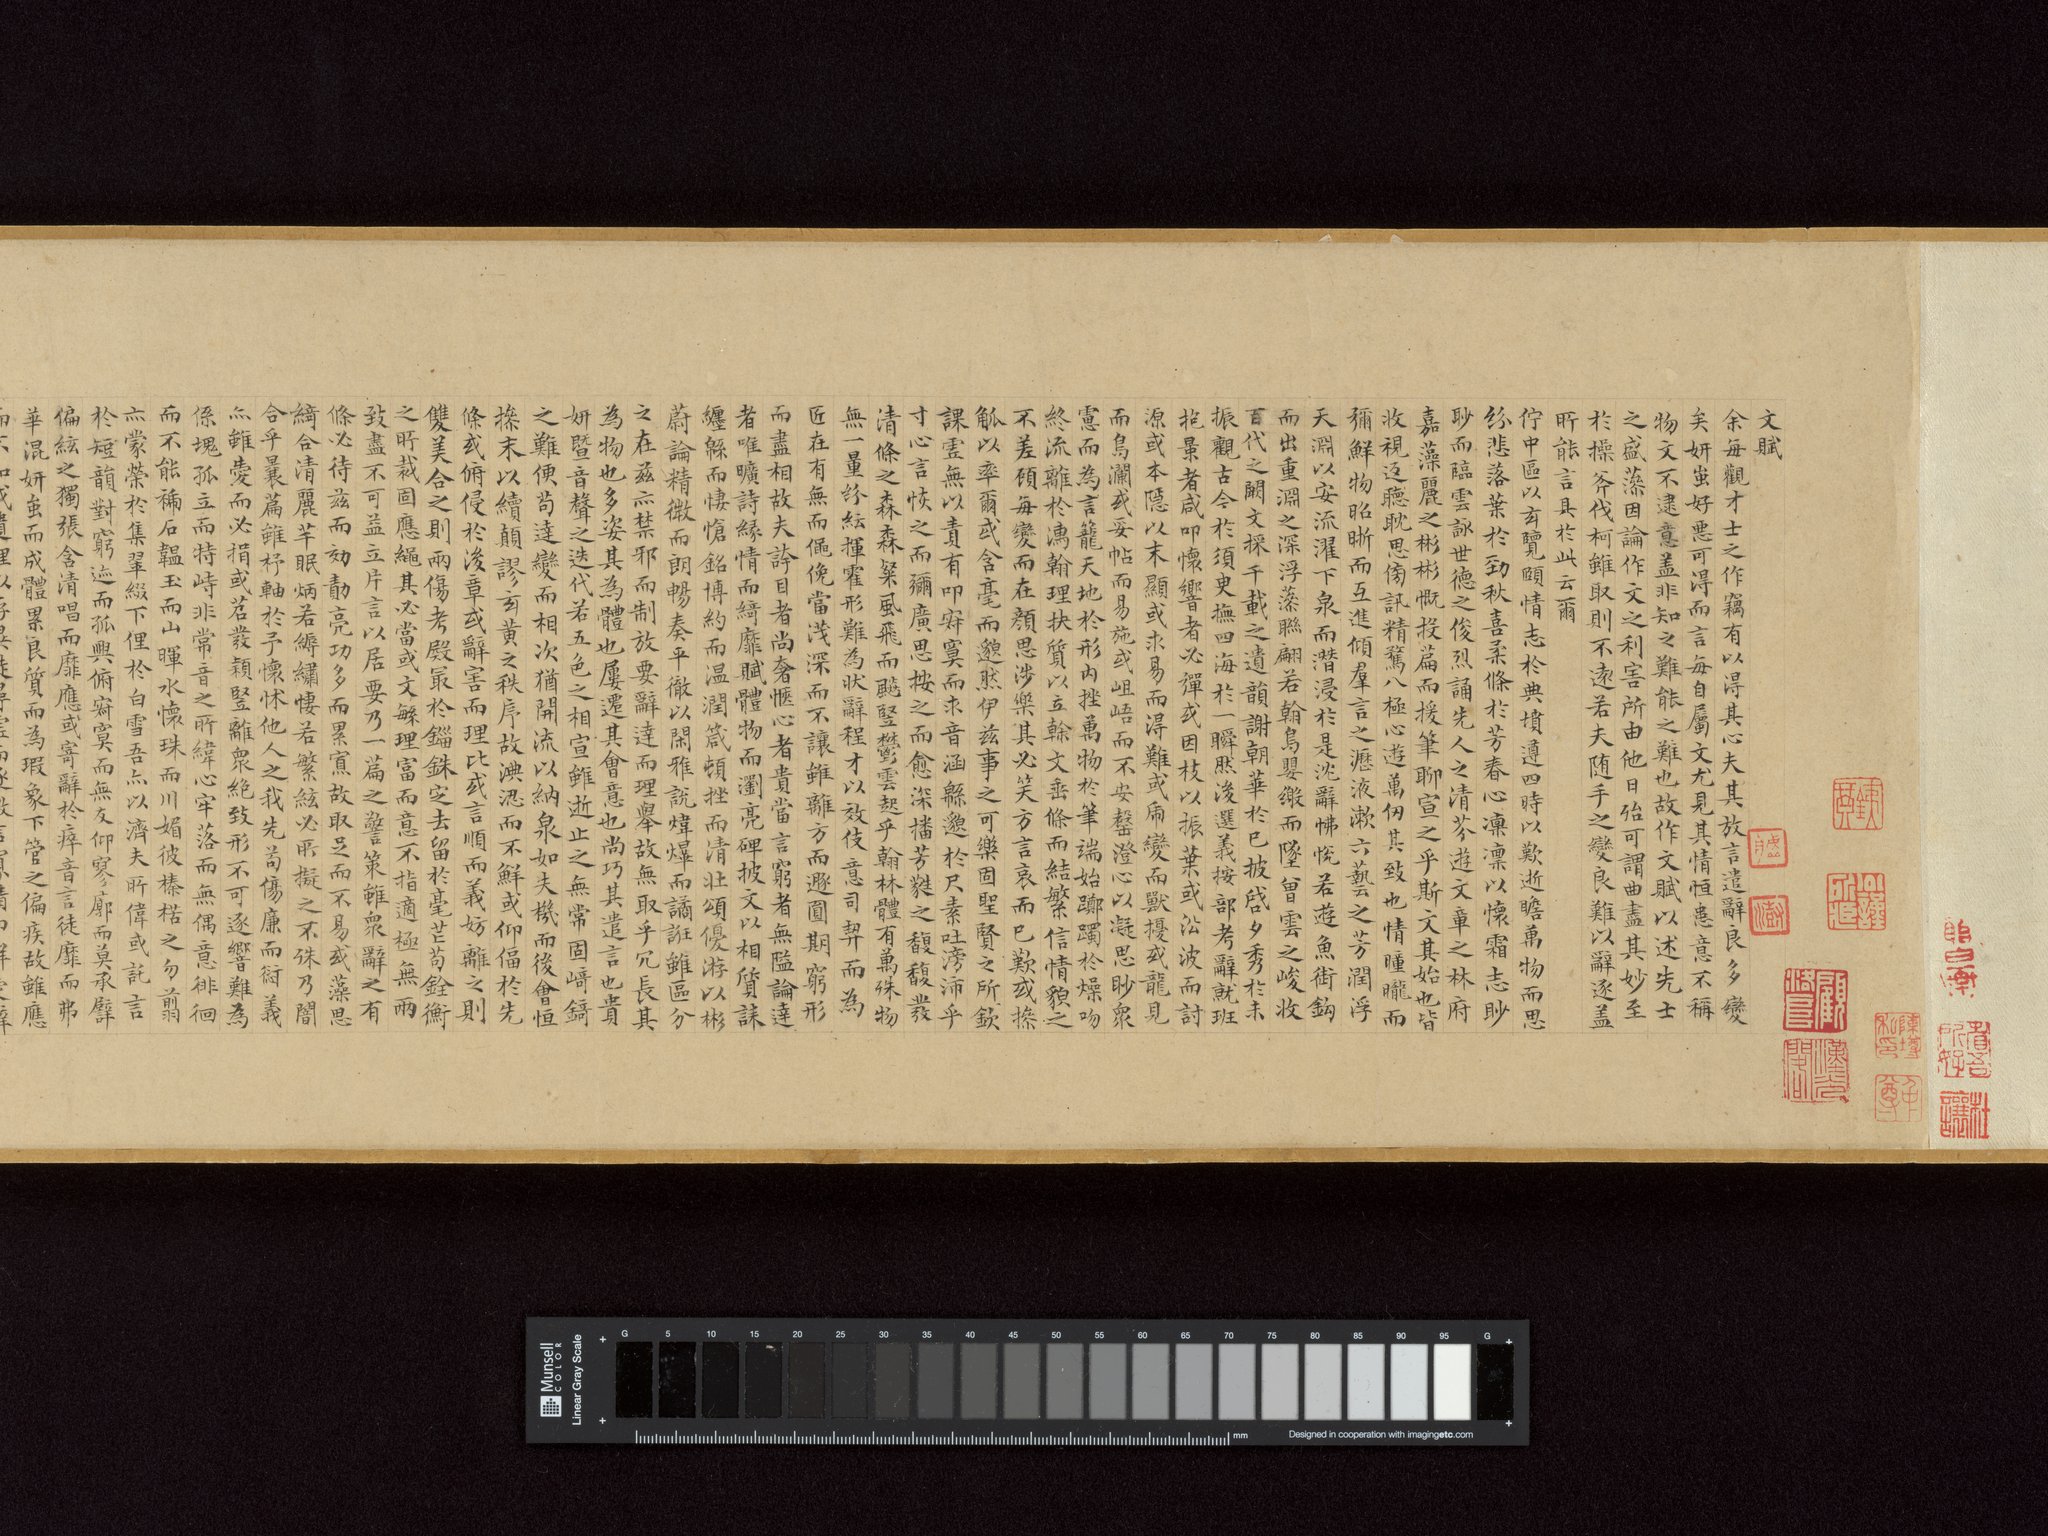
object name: handscroll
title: Lu Ji’s Essay on Literature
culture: chinese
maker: wen zhengming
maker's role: artist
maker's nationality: chinese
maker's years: 1470-1559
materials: ink, paper